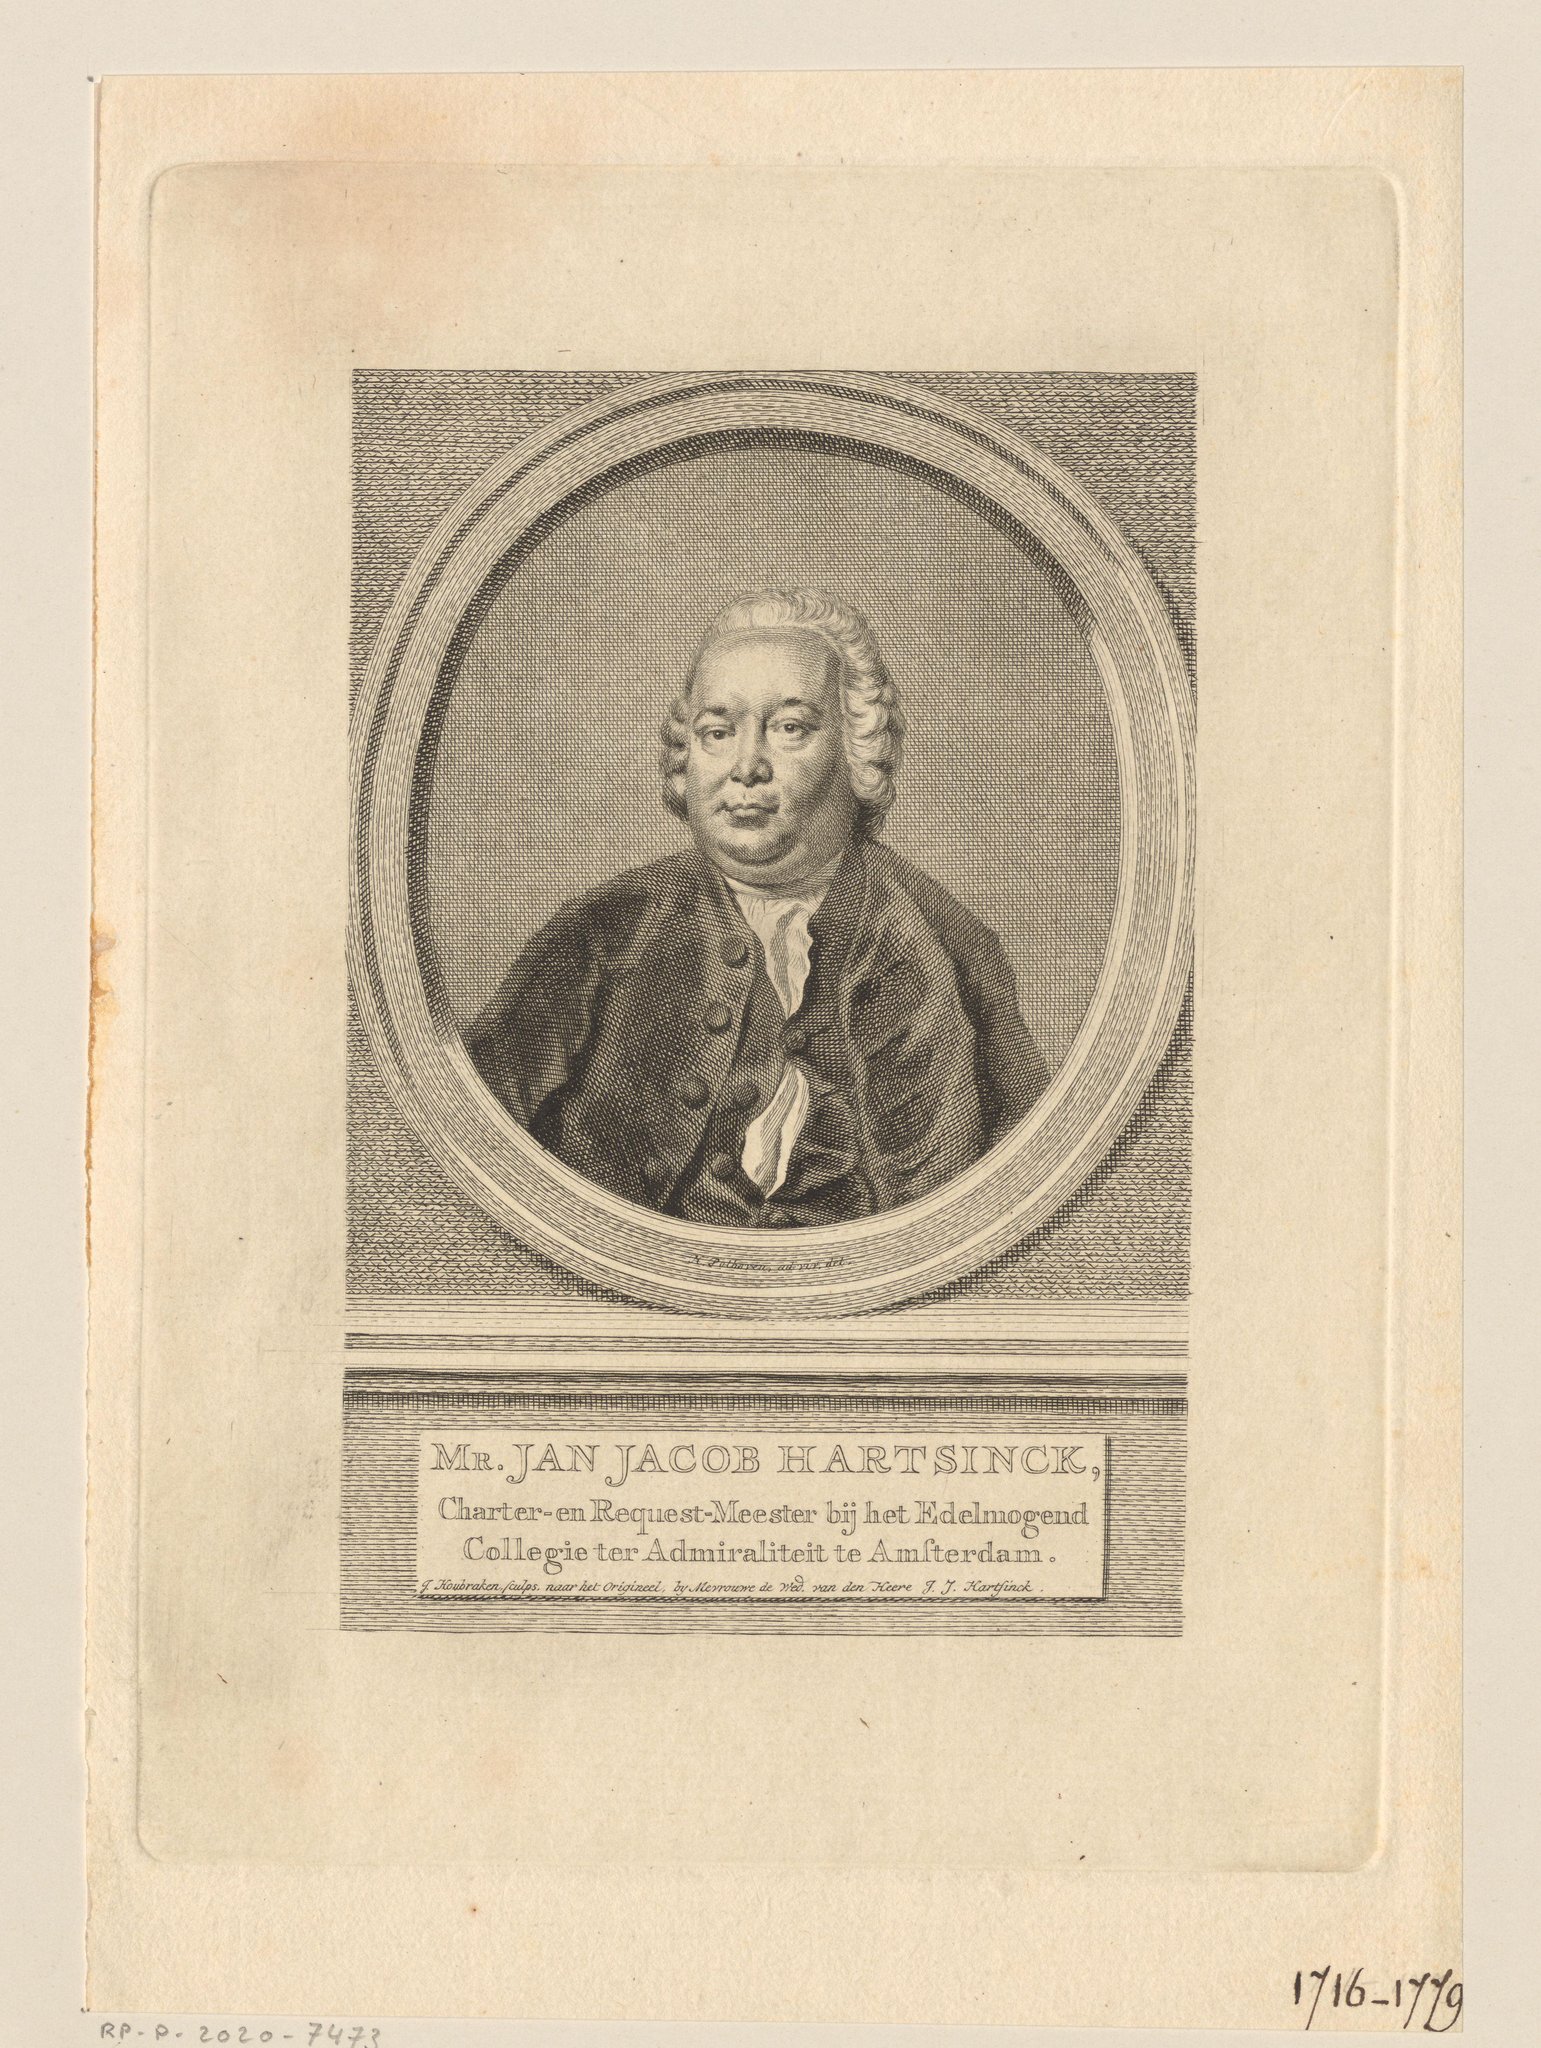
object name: print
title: Portret van Jan Jacob Hartsinck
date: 1760-1767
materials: paper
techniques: engraving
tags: amsterdam, historical persons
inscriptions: inscription: ‘1716-1779’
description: Prent mogelijk uit: Wagenaar, Jan. Amsterdam in zyne opkomst, aanwas en geschiedenissen (...). Amsterdam: Isaak Tirion, 1760-1767. Prent later ook uitgegeven als aanvulling op: Wagenaar, Jan. Vaderlandsche historie, vervattende de geschiedenissen der nu Vereenigde Nederlanden (…). 21 dln. Amsterdam: Johannes Allart, 1790-1796.